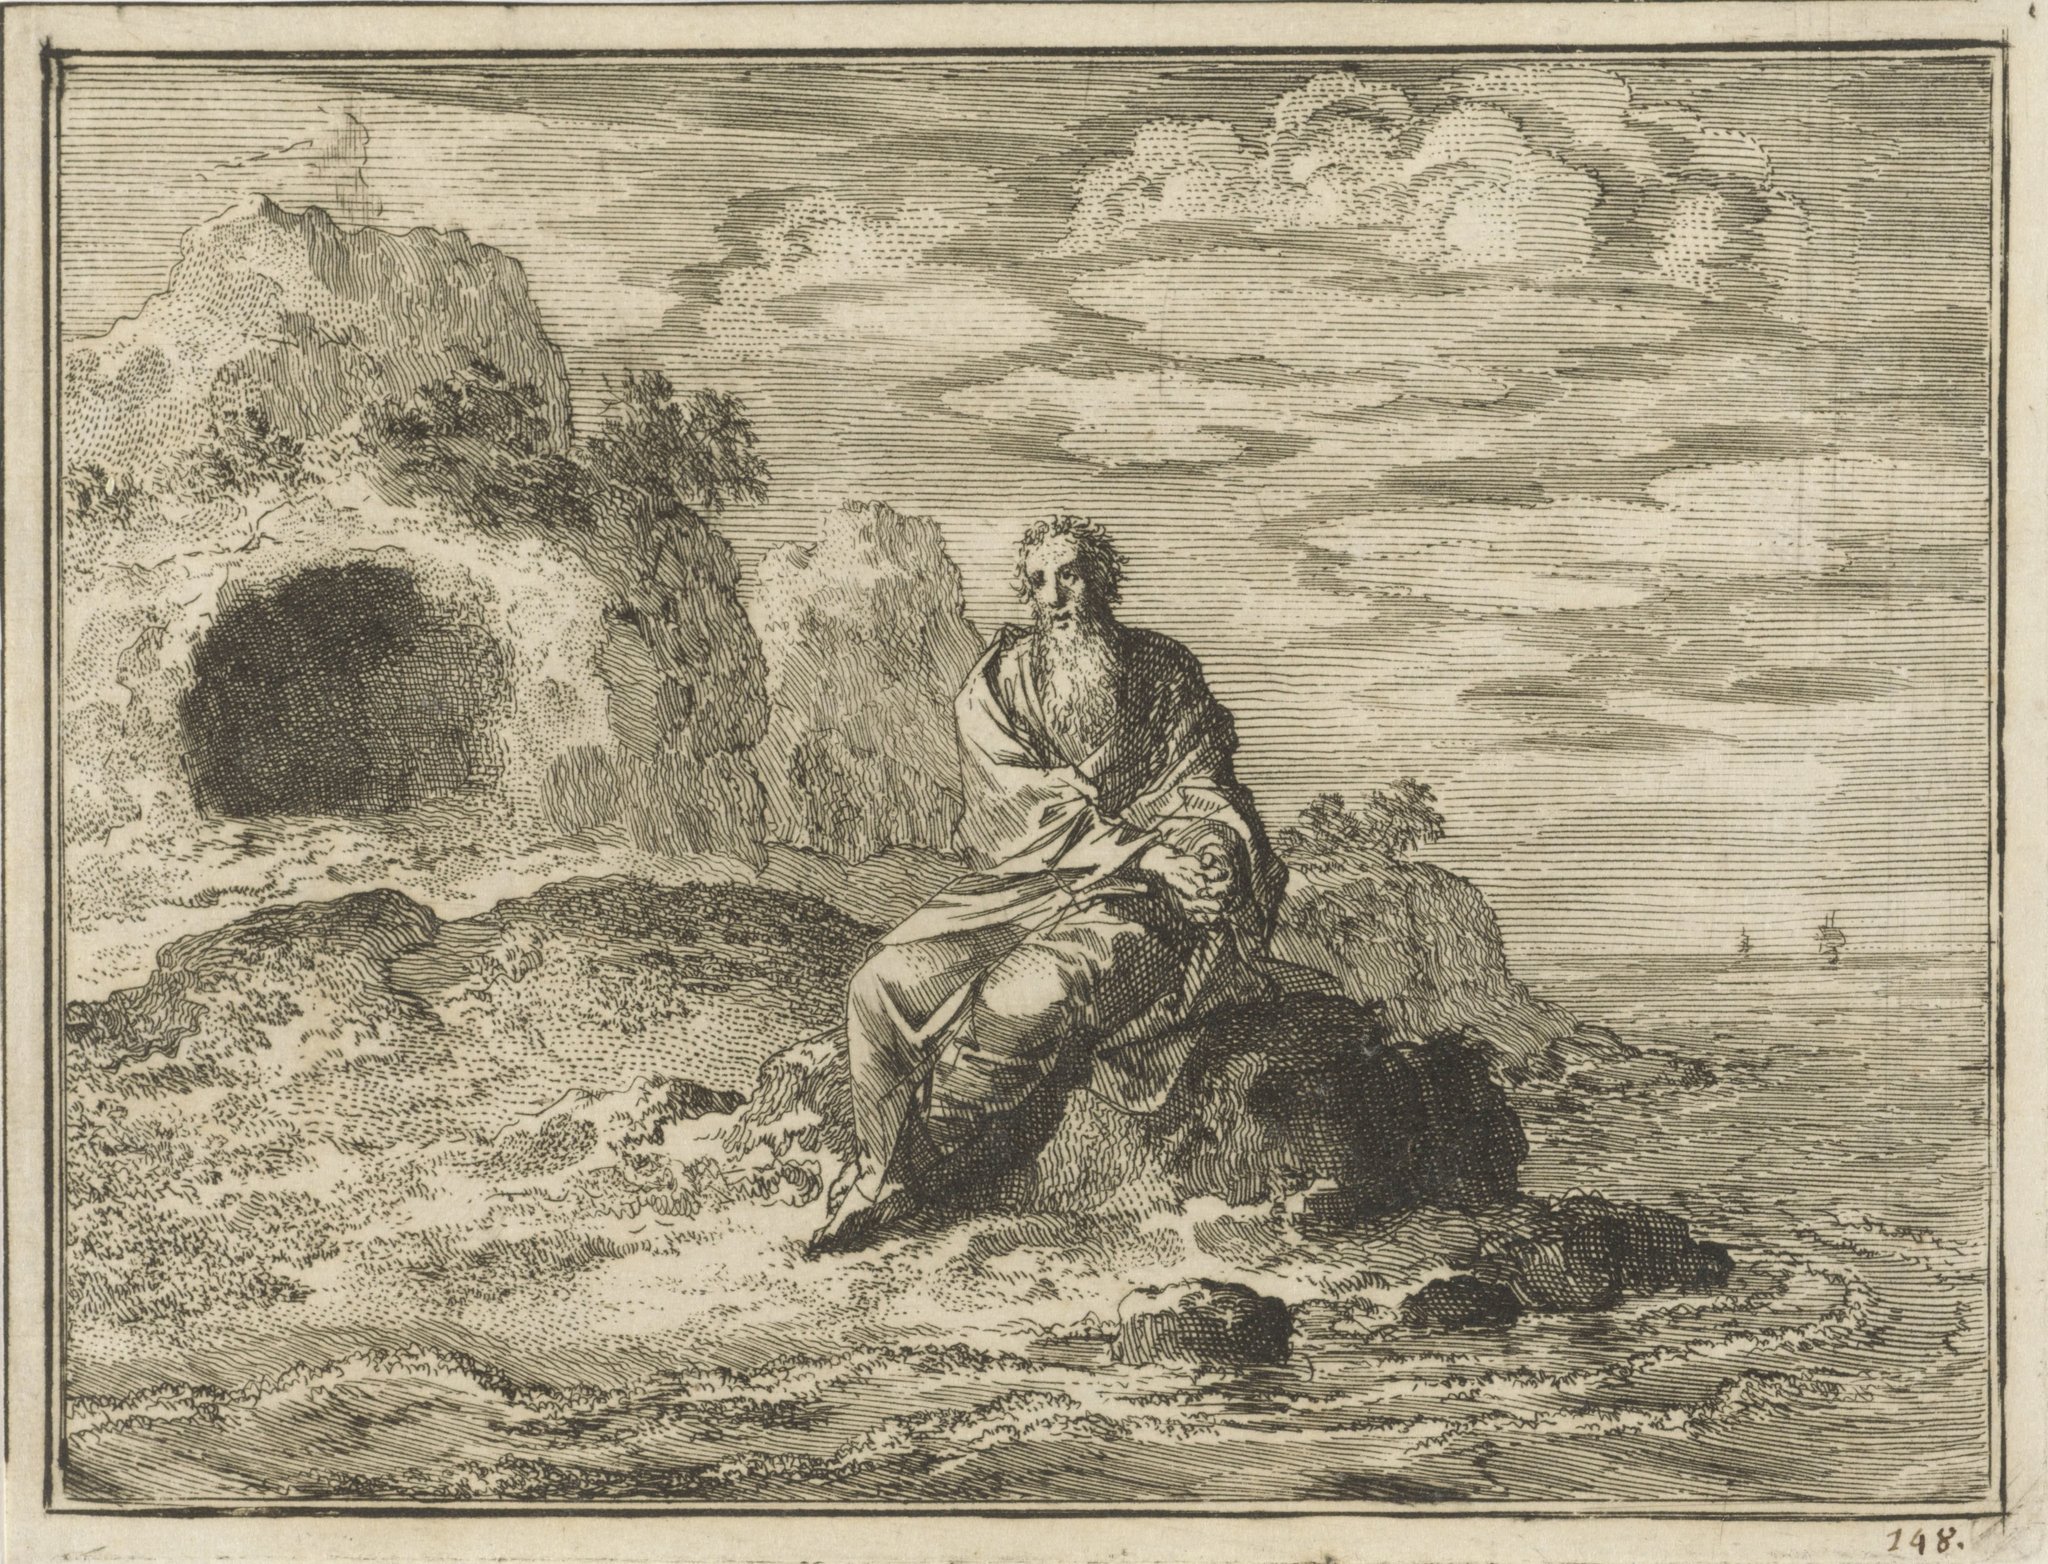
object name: print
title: Johannes de evangelist op Patmos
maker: jan luyken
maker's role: draughtsman, print maker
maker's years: 1649-1712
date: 1712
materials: paper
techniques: etching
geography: amsterdam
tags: john (writing) on the island of patmos, possibly the eagle beside him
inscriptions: collector's mark: Lugt 2228, number: ‘148’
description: Proefdruk van illustratie uit: Luyken, Jan. De schriftuurlyke geschiedenissen en gelykenissen van het Oude en Nieuwe Verbond, 2 delen. Amsterdam: Wed. Pieter Arentsz II en Cornelis van der Sys, 1712, dl. II.